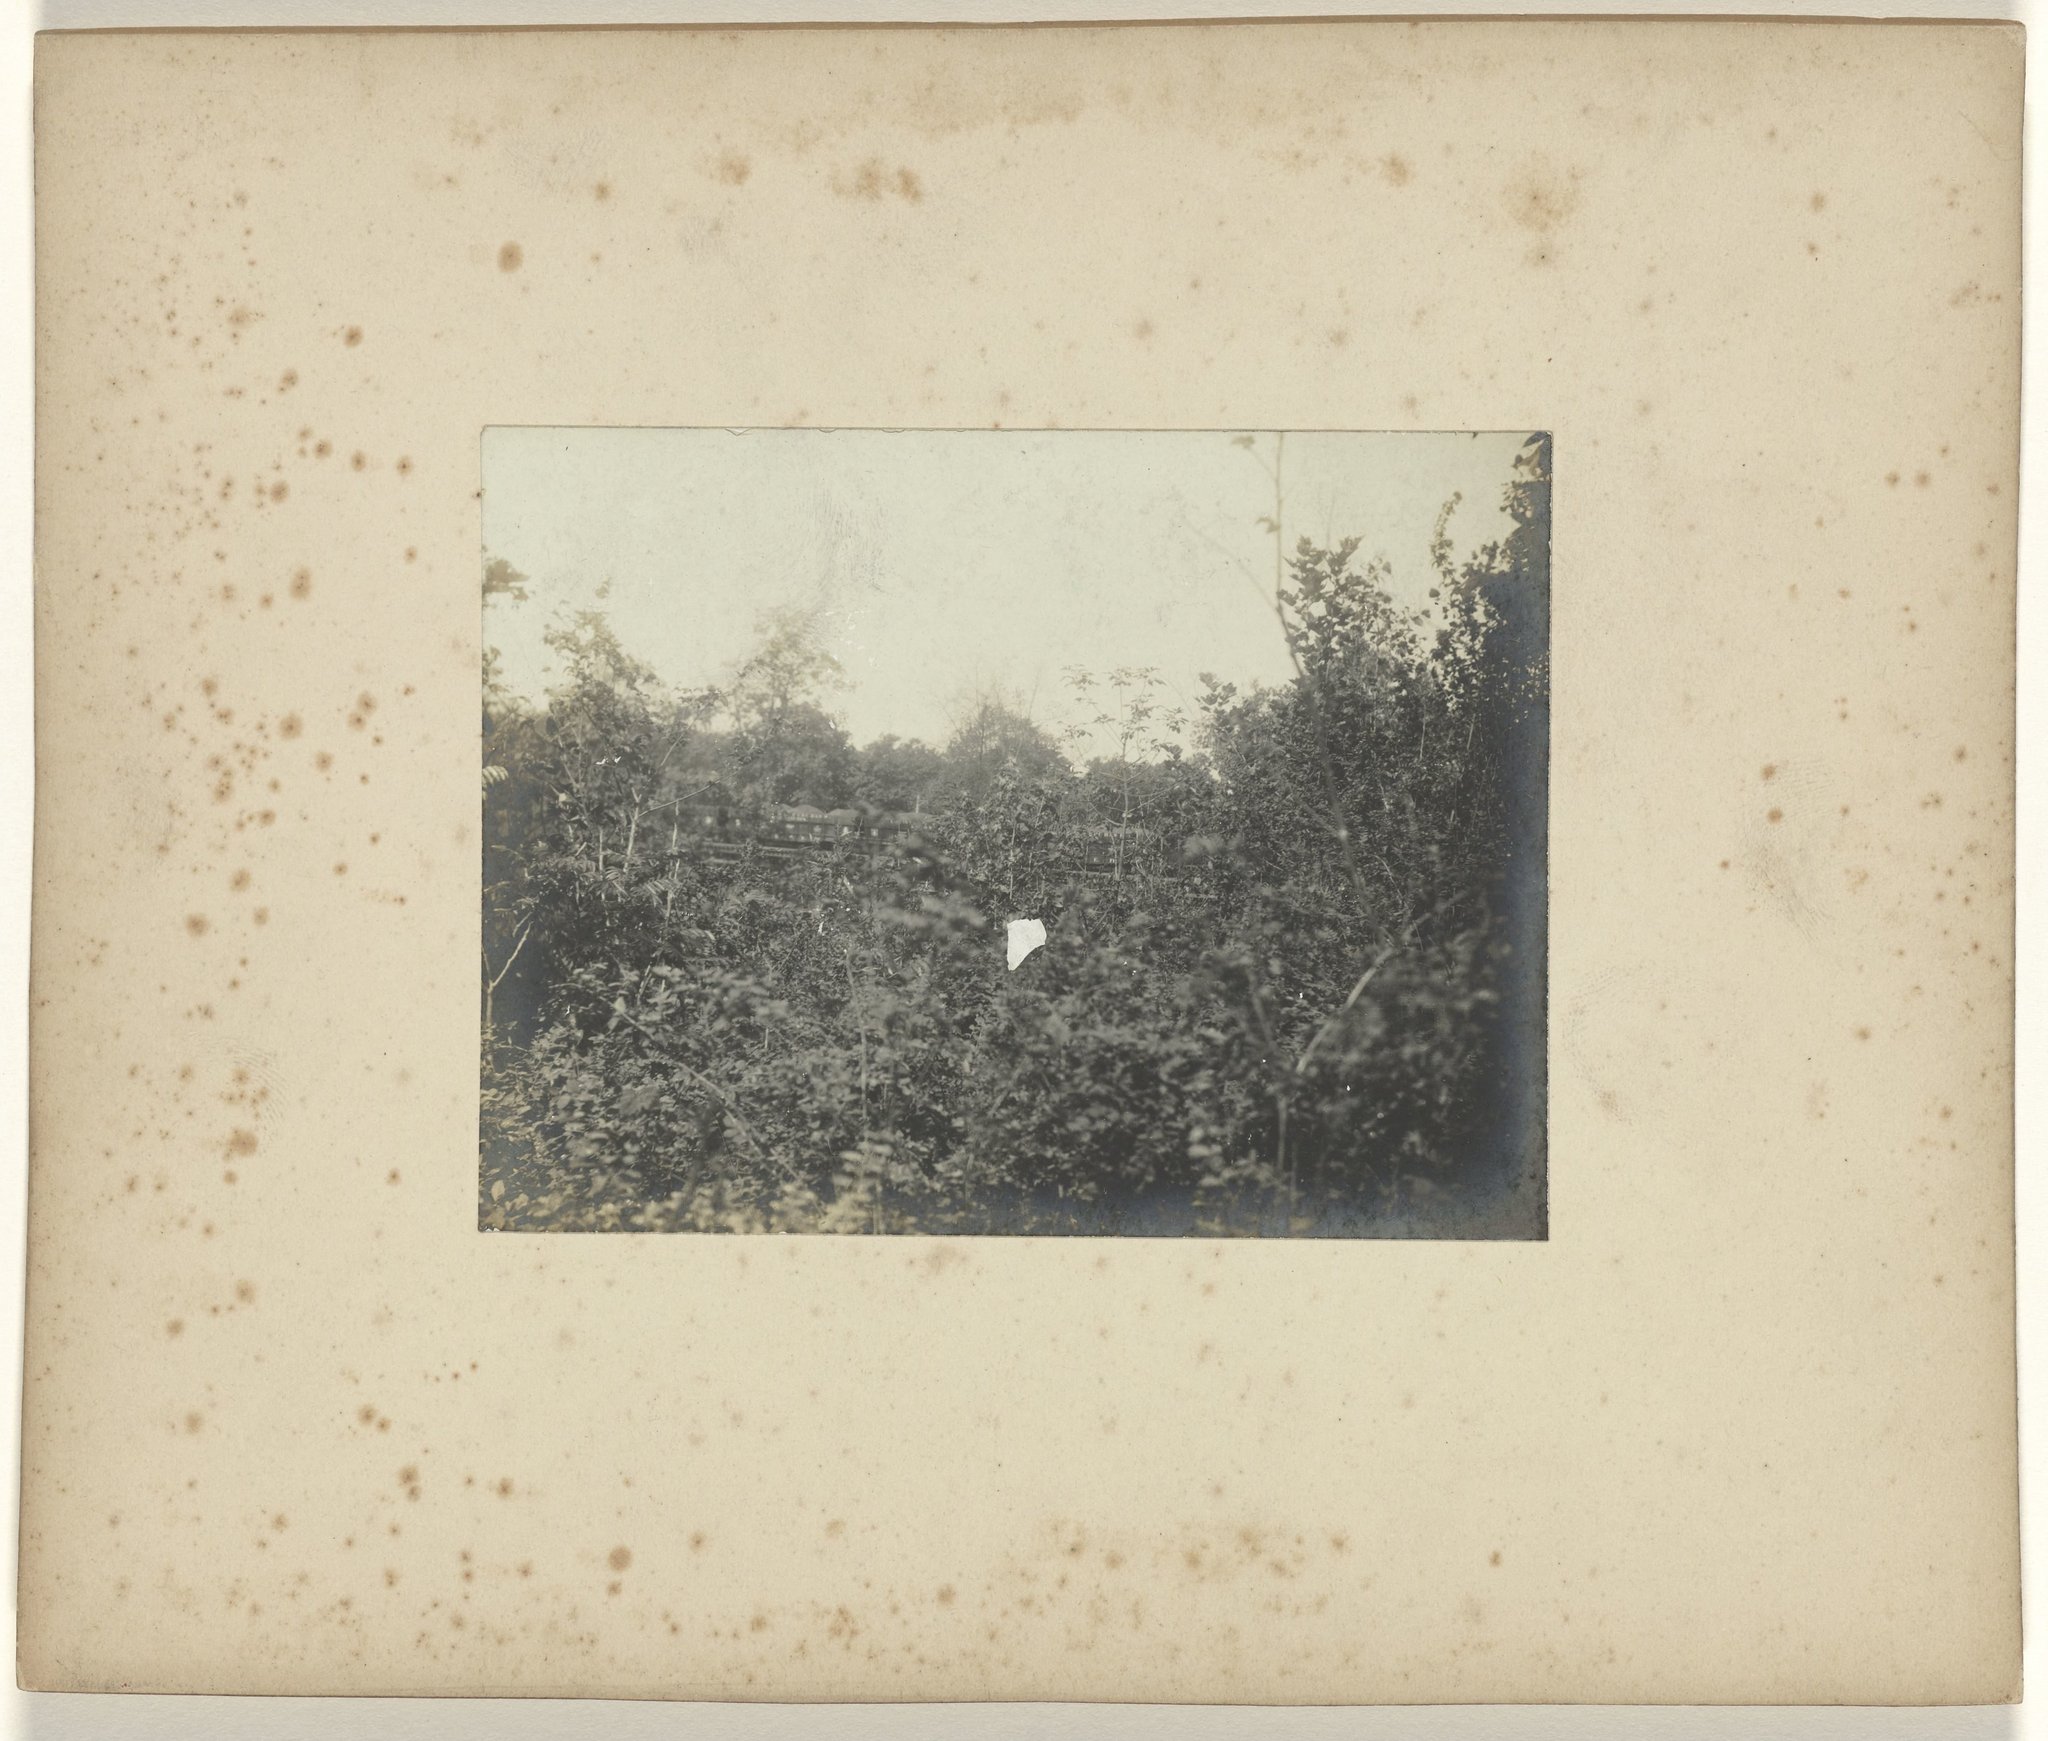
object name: photograph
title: Kolentrein in het bos achter The Art Building op de wereldtentoonstelling in St. Louis (Louisiana Purchase Exposition), 1904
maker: jan schüller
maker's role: draughtsman, painter, print maker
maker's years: 1871-1915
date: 1904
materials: cardboard, paper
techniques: gelatin silver print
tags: world fair, world exhibition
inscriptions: annotation: ‘Spoorbrug met kolentrein // in ’t Bosch achter Art Building’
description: Kolentrein in het bos achter The Art Building op de wereldtentoonstelling in St. Louis (Louisiana Purchase Exposition), 1904.